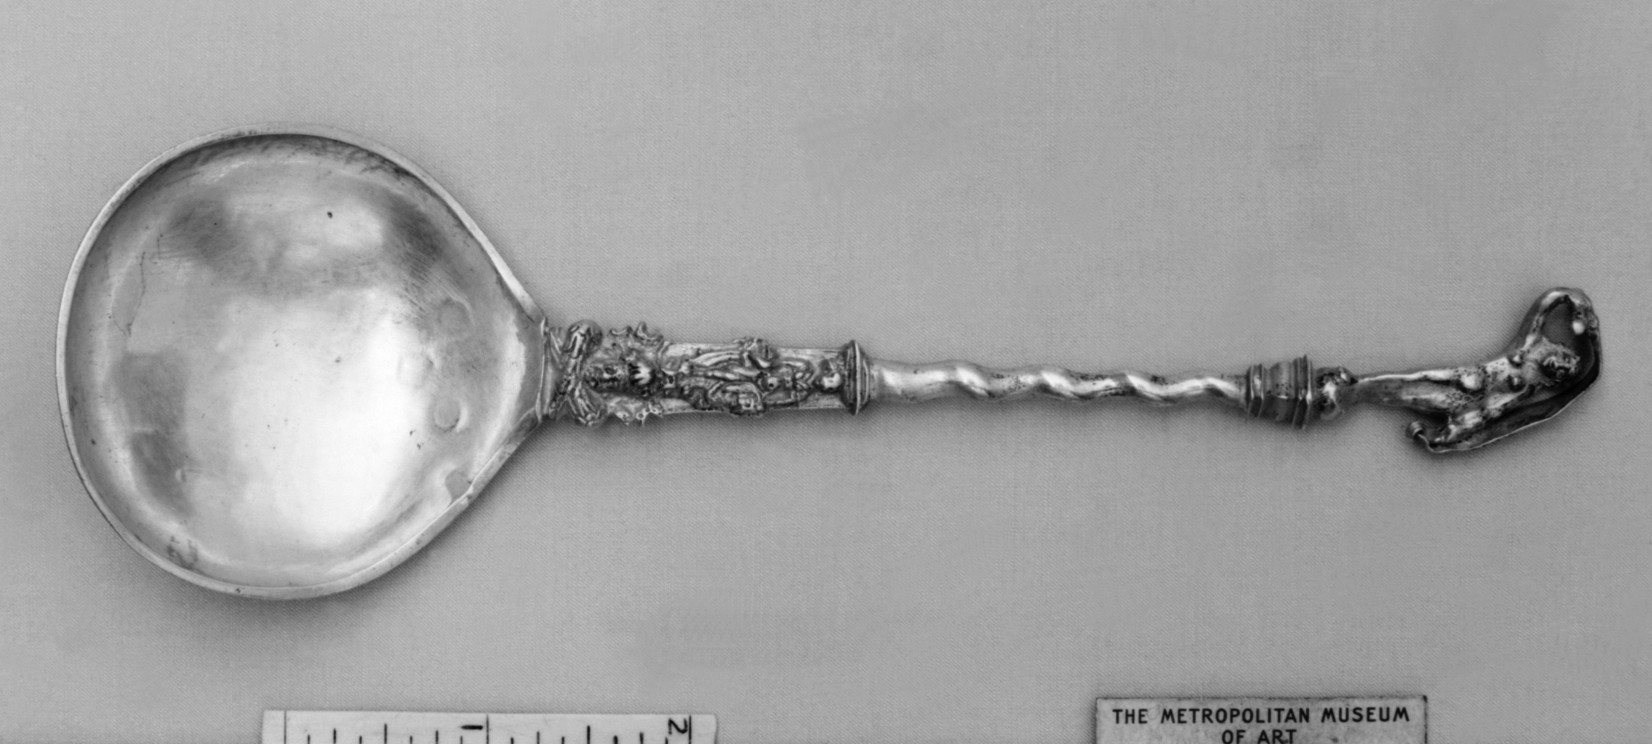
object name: spoon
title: Figure-top spoon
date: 1629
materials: silver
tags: women